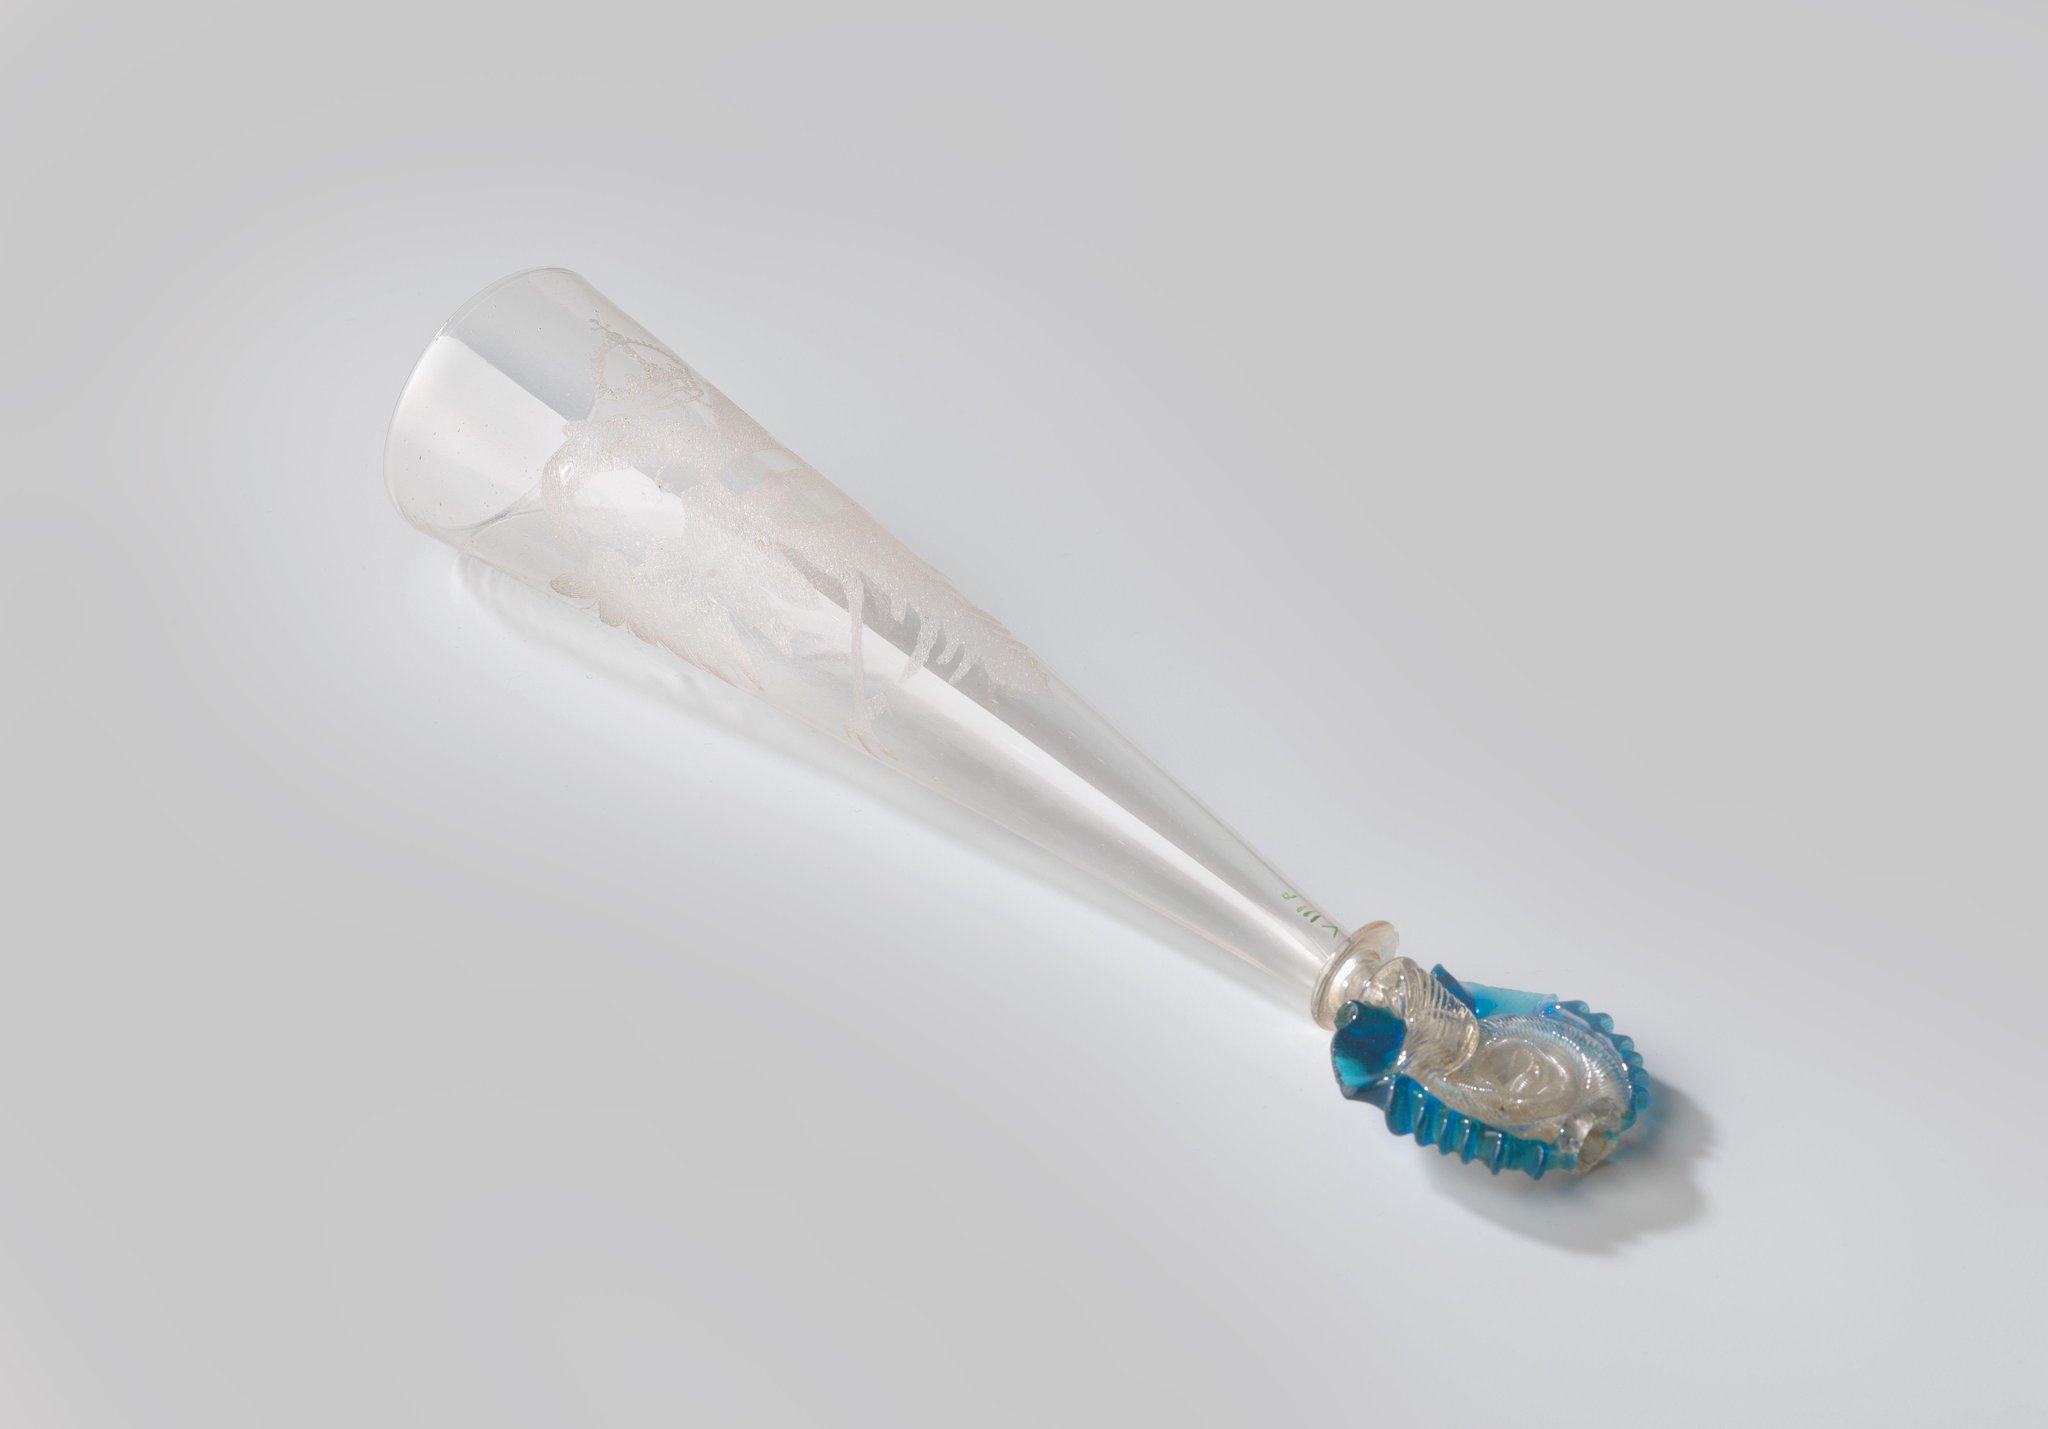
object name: flute glass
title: Fluitglas met het wapen van Bohemen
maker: Anonymous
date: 1650-1700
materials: glass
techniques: diamond point engraving, façon de venise, glassblowing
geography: germany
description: Fluitglas met stam, opgebouwd uit een getordeerde buis. Hoge trechtervormige kelk boven een schijf. Op de kelk in diamantgravure de keizerlijke adelaar met het gekroonde wapen van Bohemen in het hart van de adelaar. Voet en deel van de stam ontbreekt.